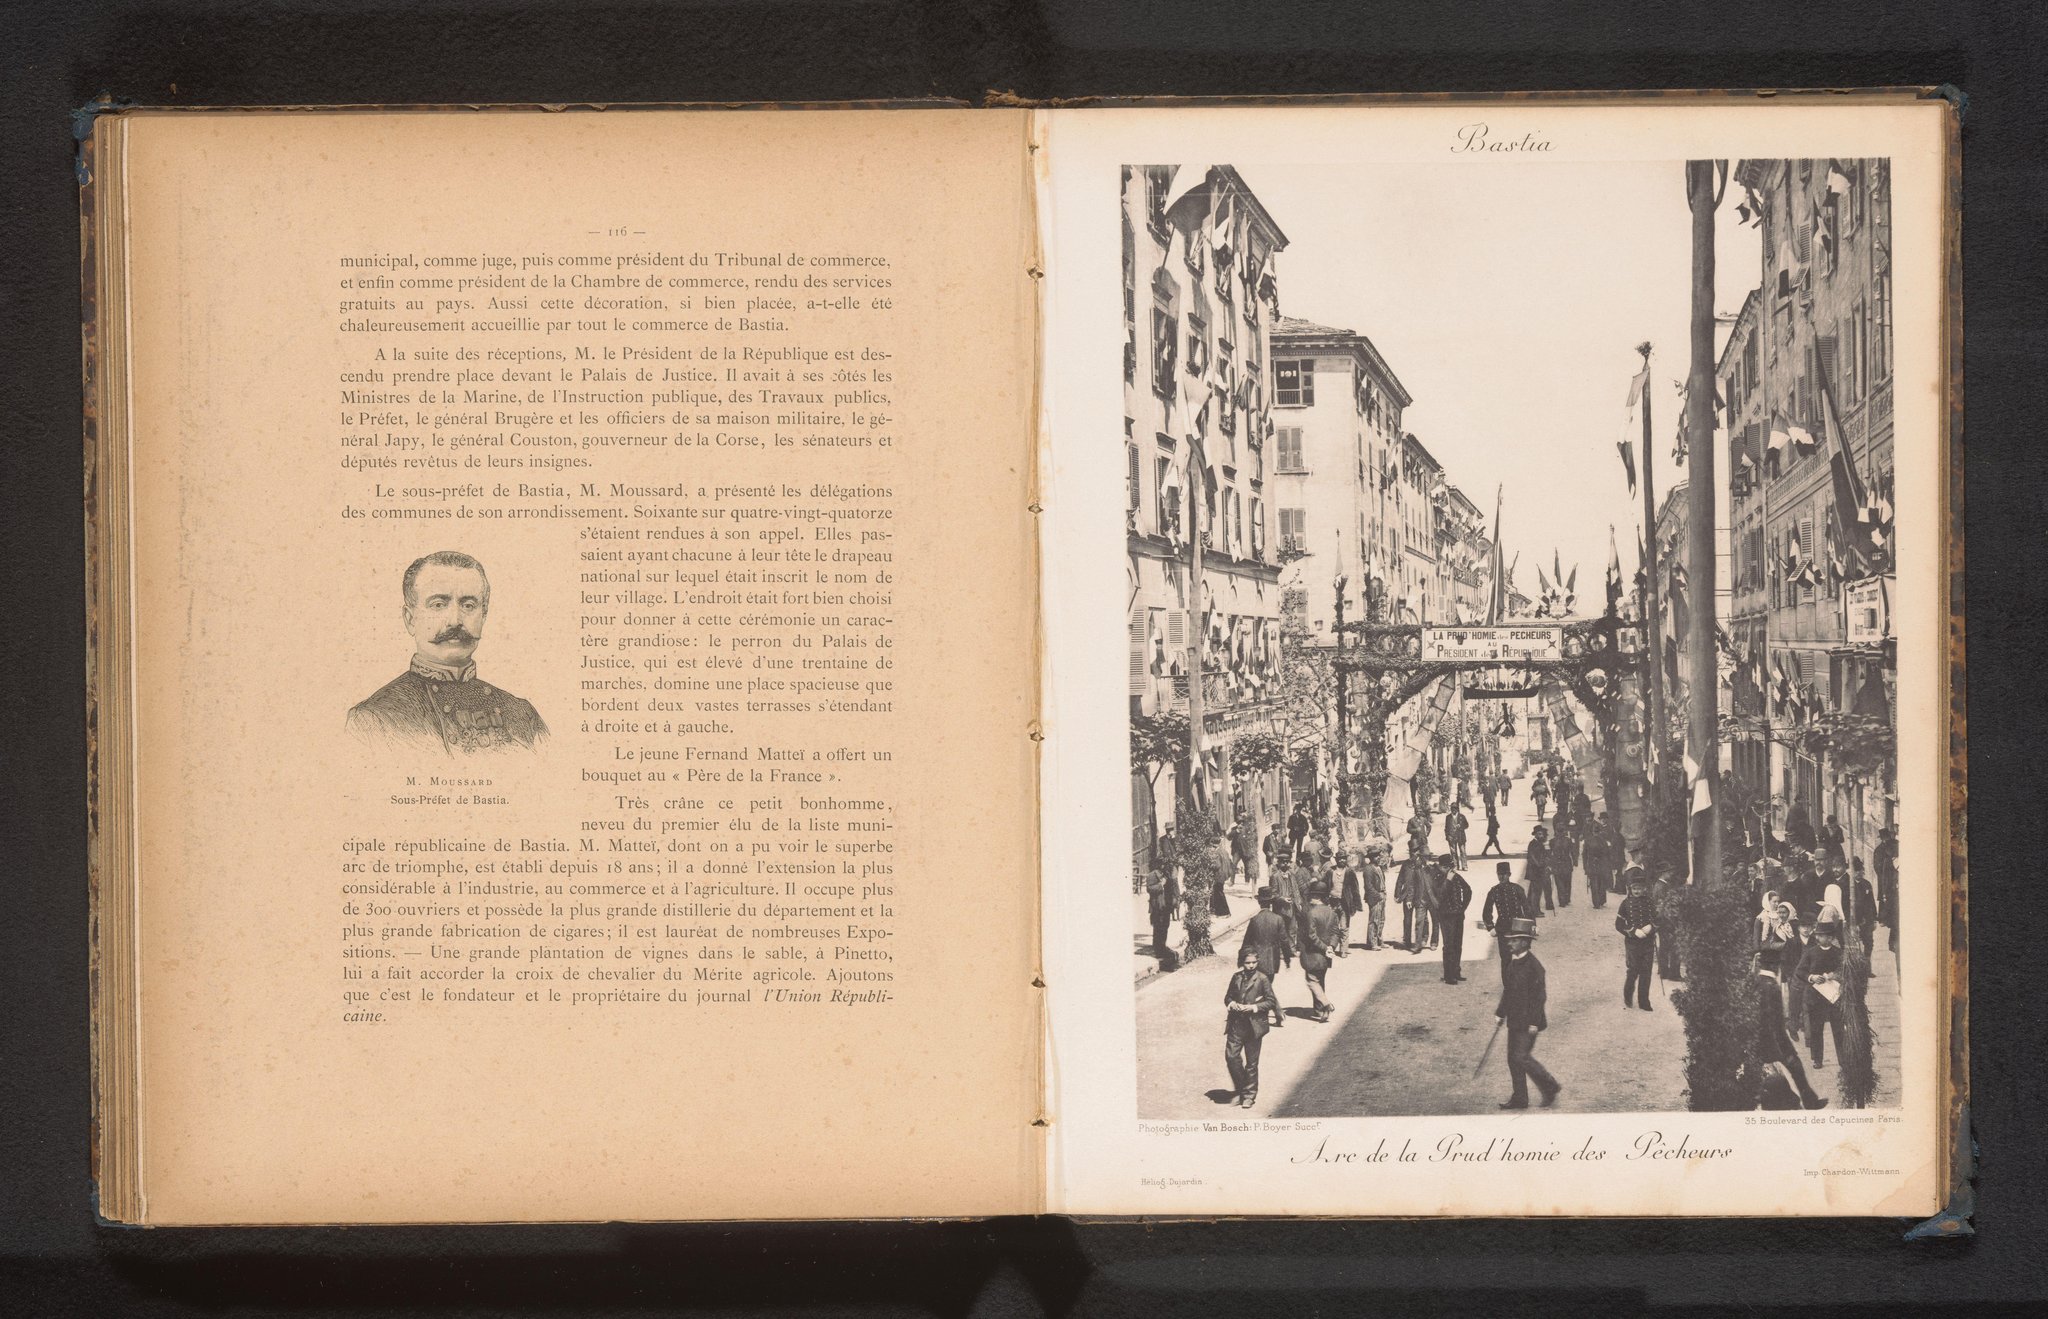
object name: page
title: Arc de la Prud'homie de pêcheurs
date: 1888-1890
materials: paper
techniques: photoaquatint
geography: bastia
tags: triumphal arch, triumphal entry and public reception, pageant, 'entrée solennelle', 'joyeuse entrée'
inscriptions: inscription: ‘35 Boulevard des Capucines Paris’, inscription: ‘Bastia’